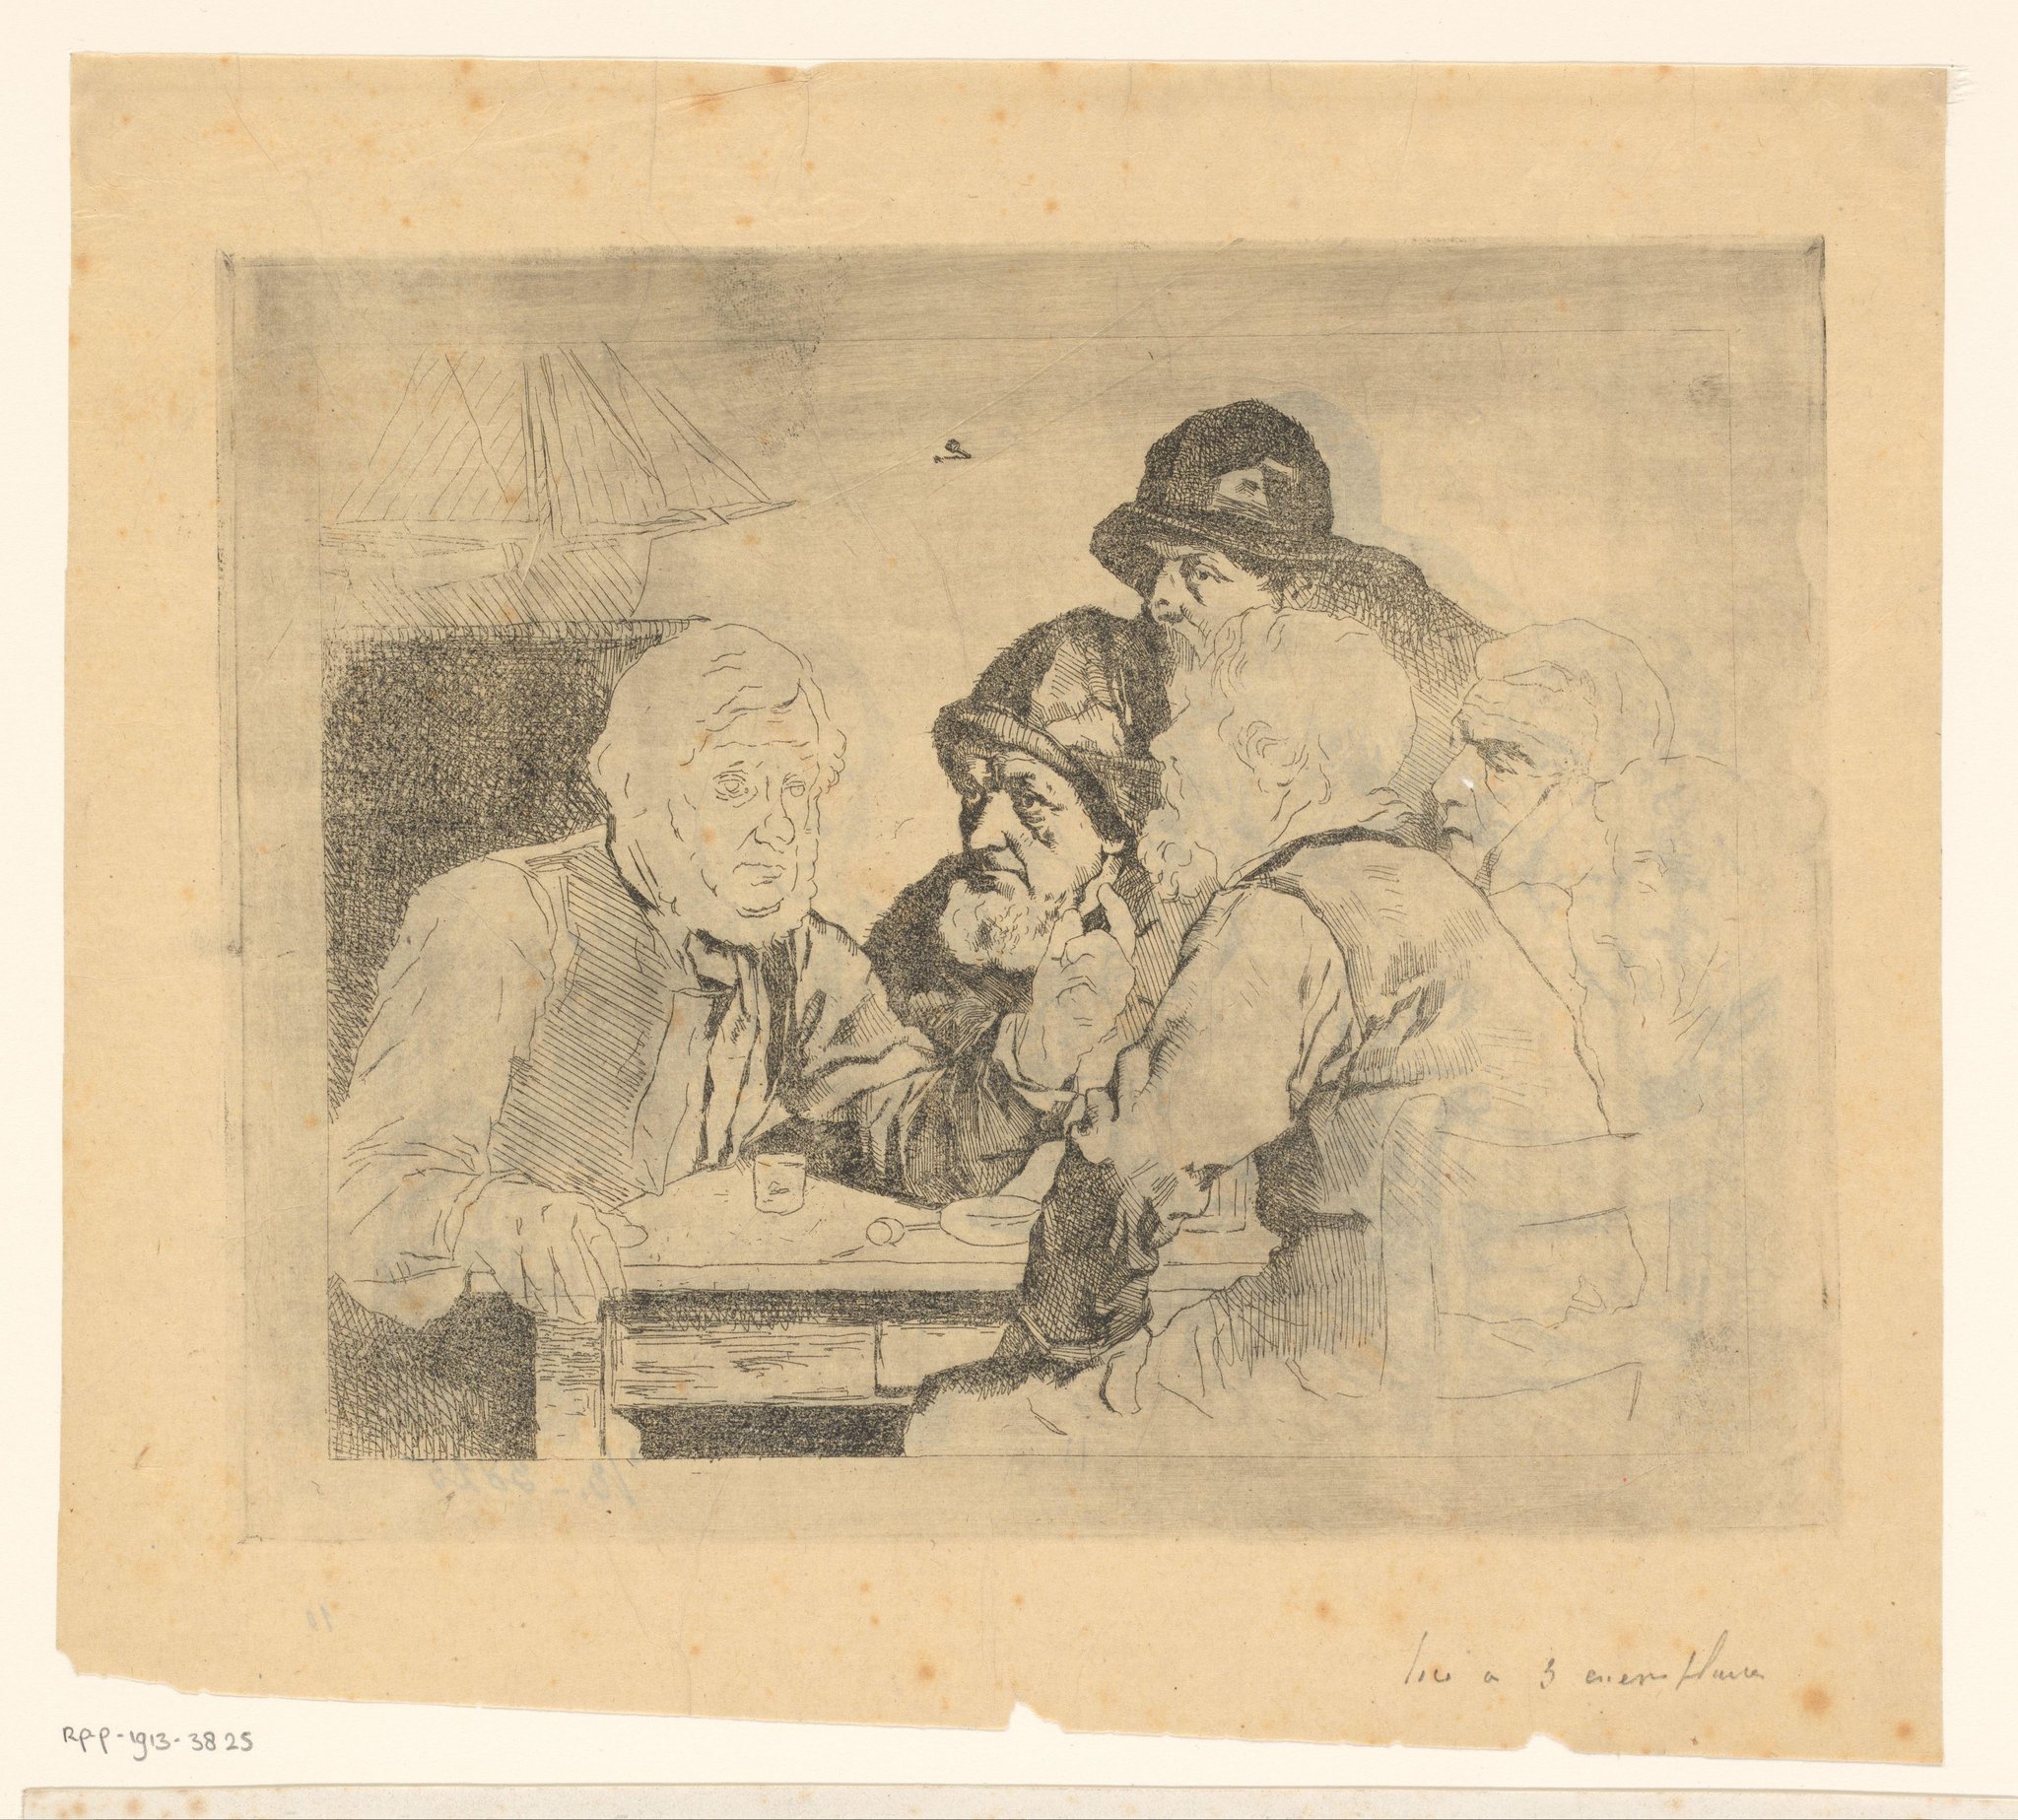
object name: print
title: Zeelieden gezeten aan tafel luisterend naar een van hen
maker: piet verhaert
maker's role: print maker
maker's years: 1852-1908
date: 1879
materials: paper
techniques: etching, intaglio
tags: story teller; listening to story teller, table, seaman, ship-model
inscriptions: collector's mark: Lugt 2228, inscription: ‘Tire à 3 exemplaire’